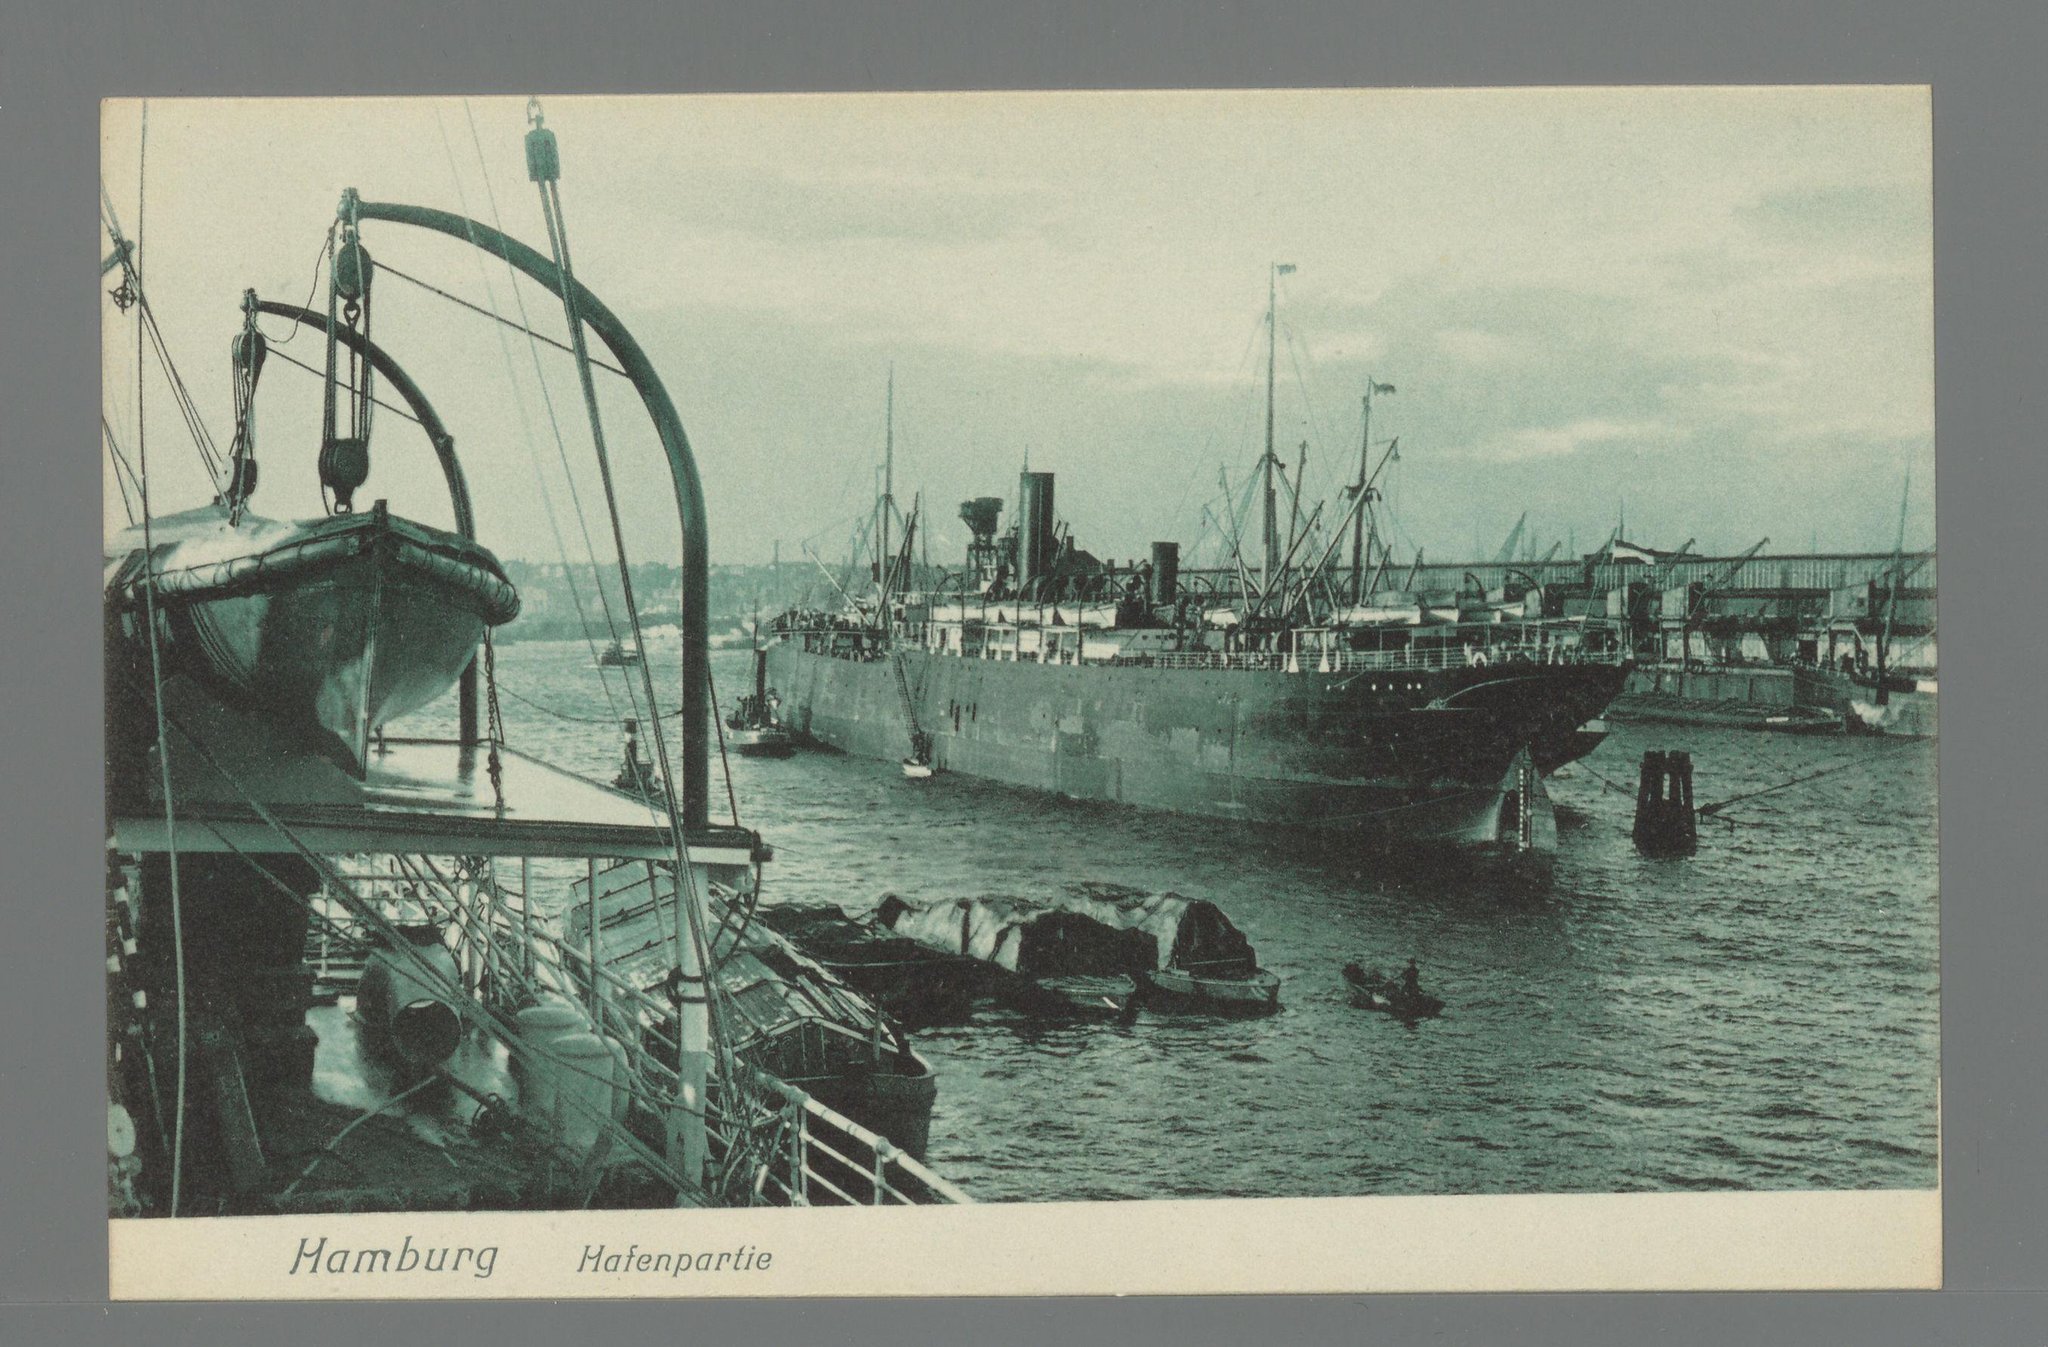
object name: ansichtkaart, prentbriefkaart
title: Luxusdruck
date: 1905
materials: cardboard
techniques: photograph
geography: hamburg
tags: harbour, steamship, motorship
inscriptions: date